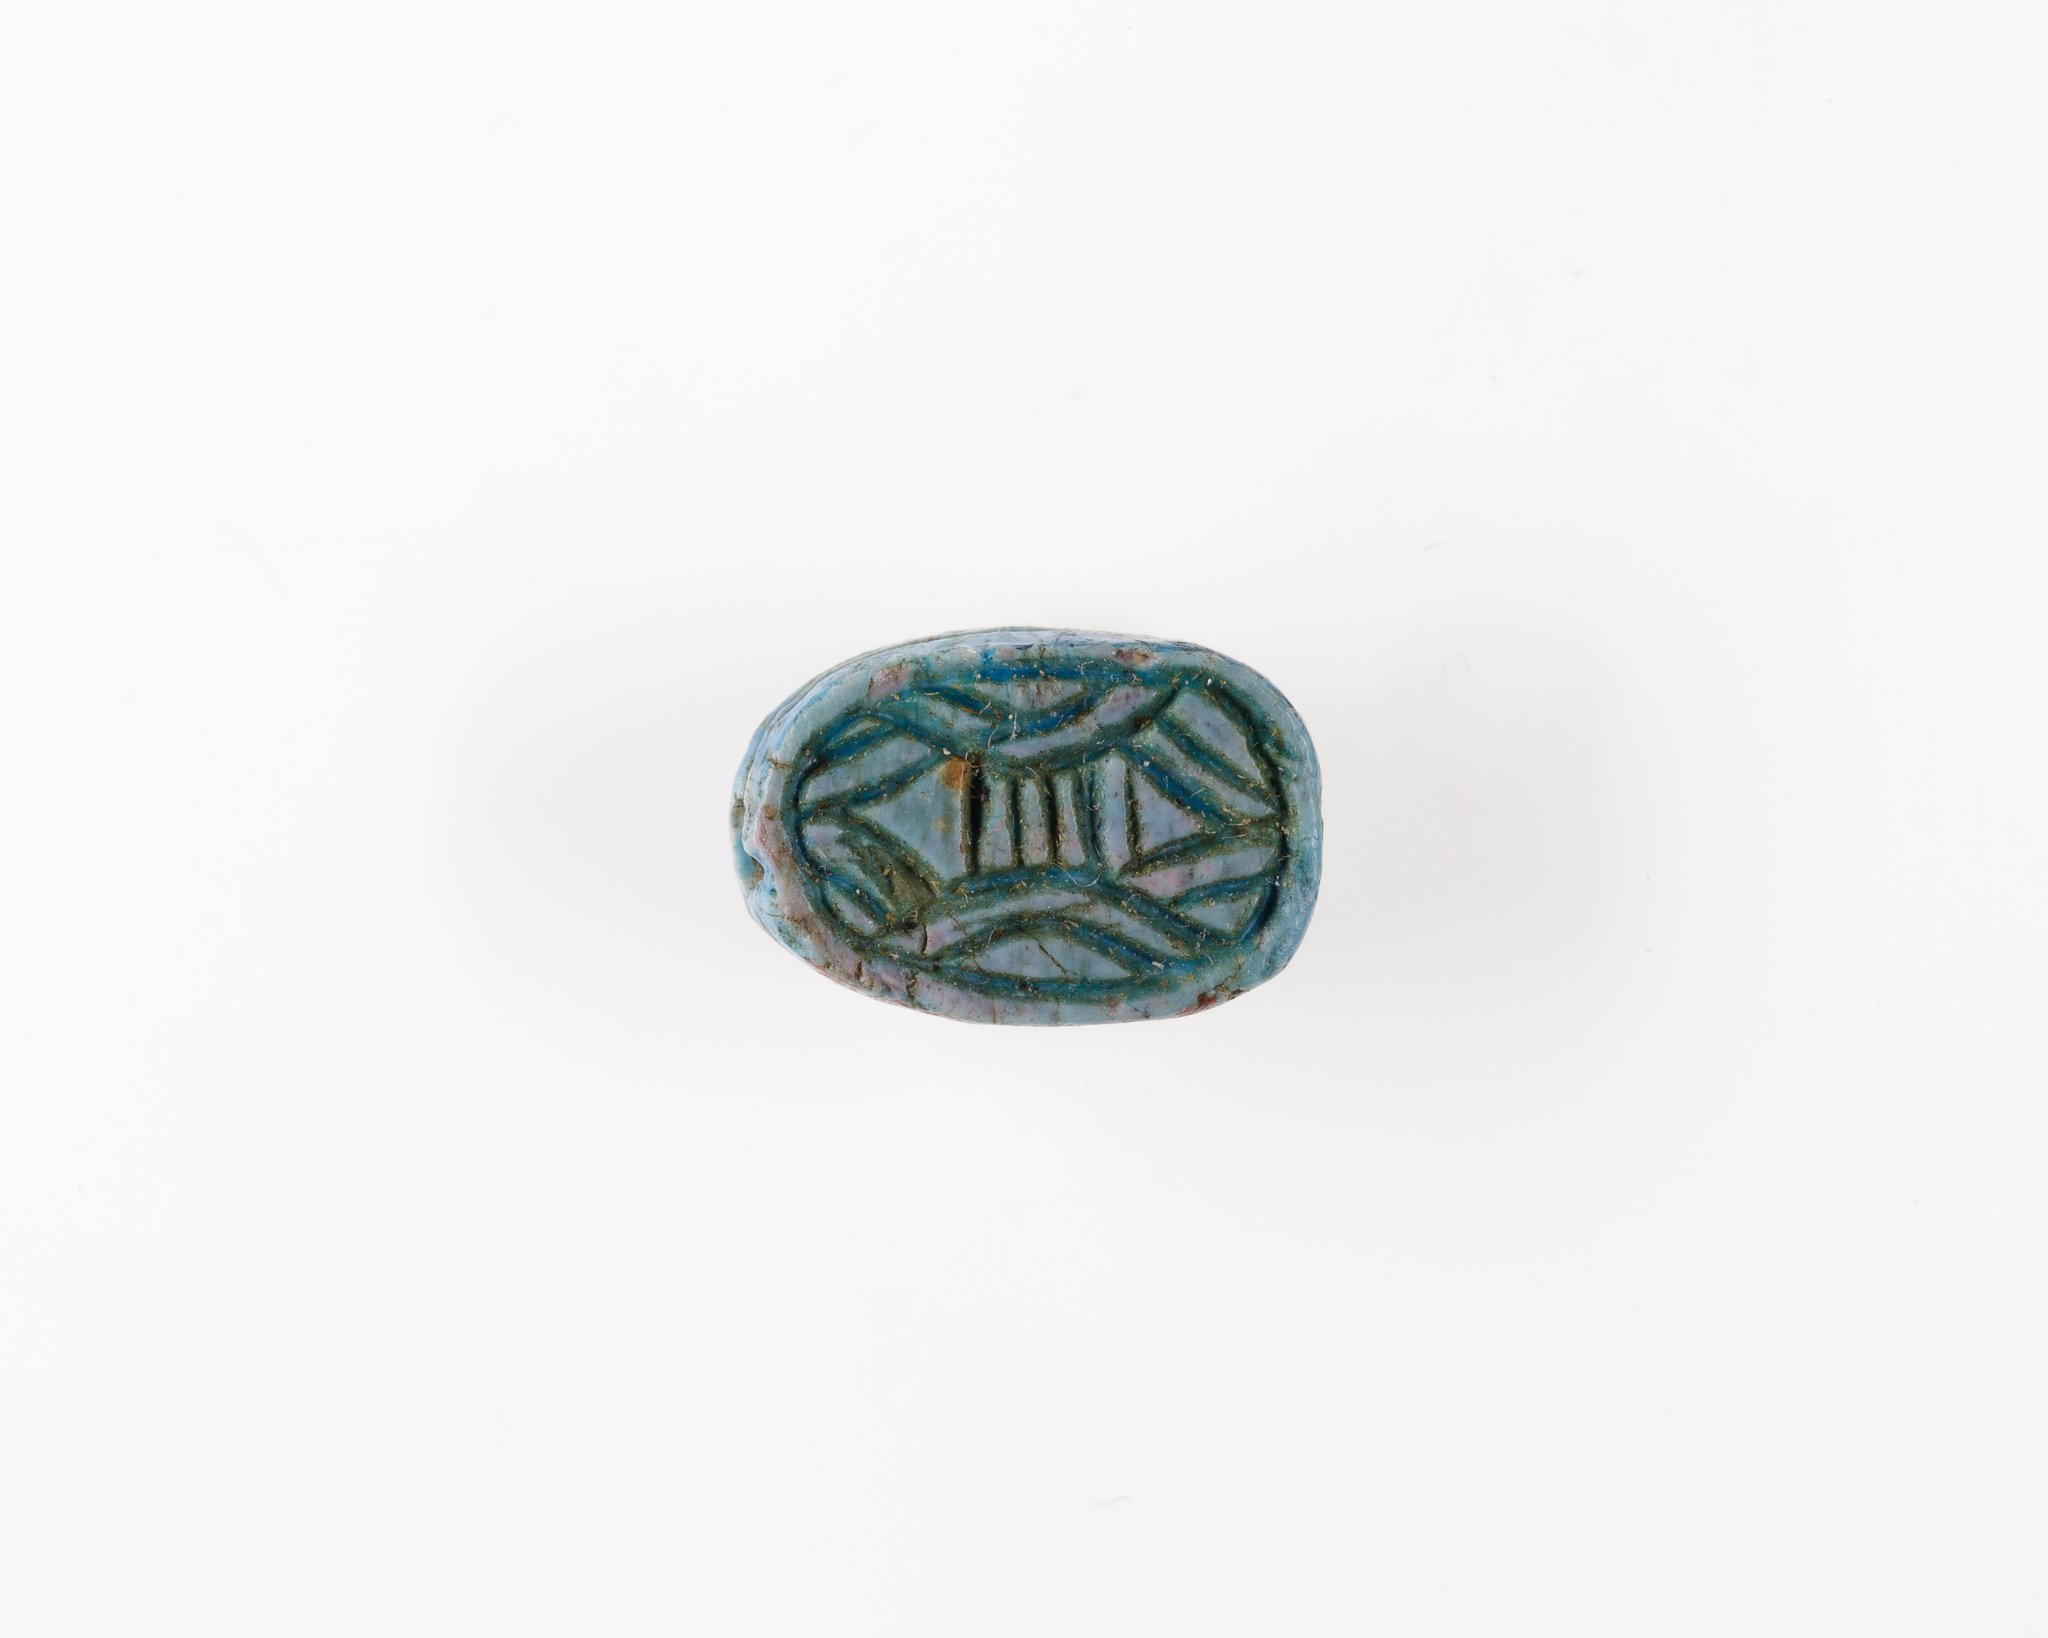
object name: scarab, geometric motif, lotus flower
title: Scarab with Double Lotus Design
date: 1981-1802 BCE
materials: stone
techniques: glazing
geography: egypt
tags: scarabs